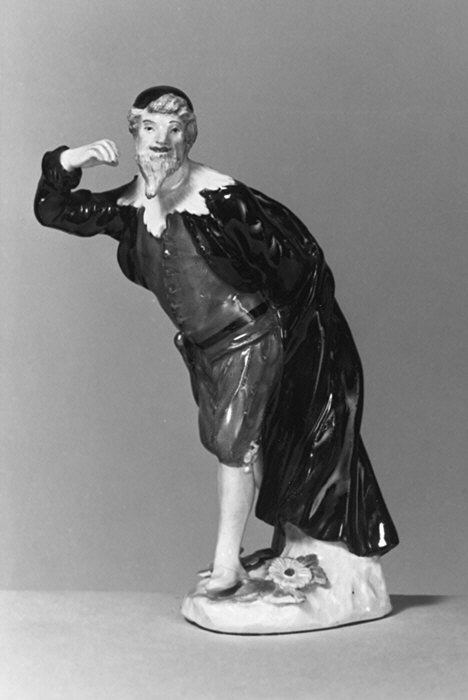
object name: figure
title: Pantaloon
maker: meissen manufactory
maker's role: manufactory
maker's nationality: german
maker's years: 1710-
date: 1743-1744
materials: hard paste porcelain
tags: men